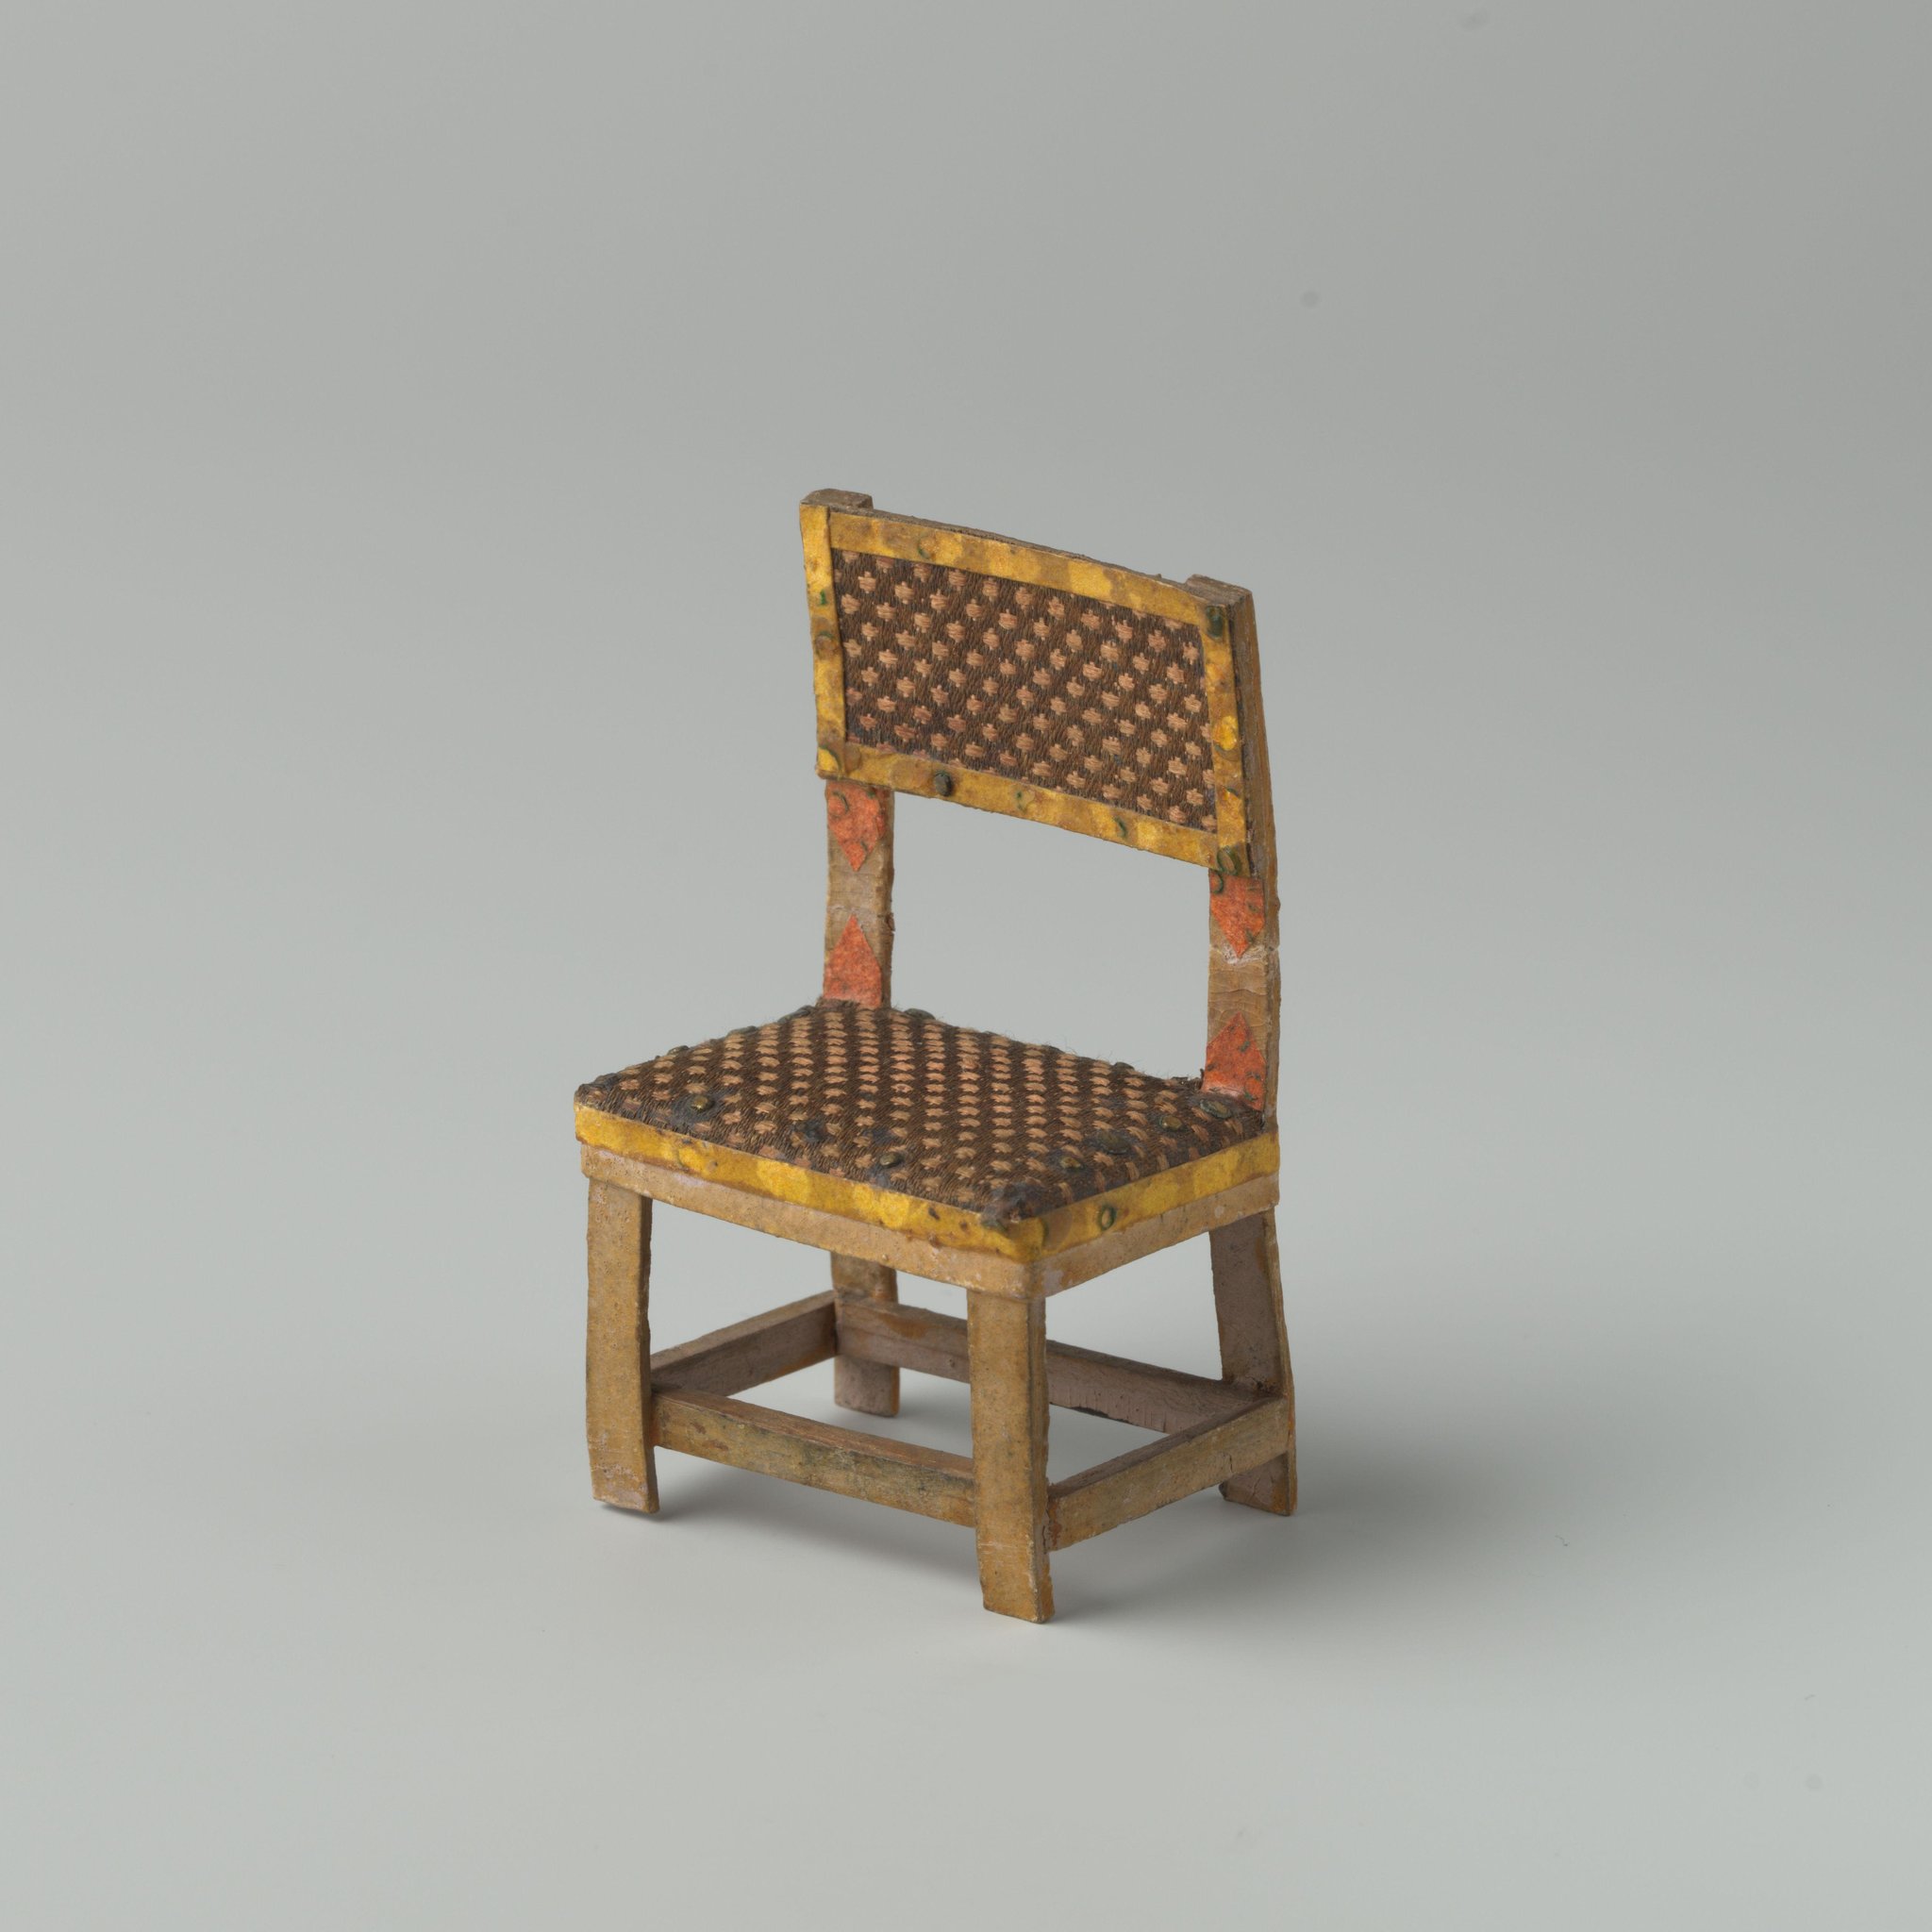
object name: miniature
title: Stoel, vervaardigd van bordpapier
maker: Anonymous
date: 1676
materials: gouache, metal, board, silk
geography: amsterdam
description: Stoel, vervaardigd van bordpapier, met beklede zitting en rug. De rugstijlen, voorpoten, dwarsregels en onderkant zijn zachtpaars gekleurd. Zitting en rug zijn gestoffeerd en bekleed met zijde met bruine stippels op een zwarte ondergrond, afgezet met band van geelgelakt papier, waarop nagels van metaal. De papieren band loopt even door op de stijl tussen zitting en rug en eindigt in een punt van roodgekleurd papier.